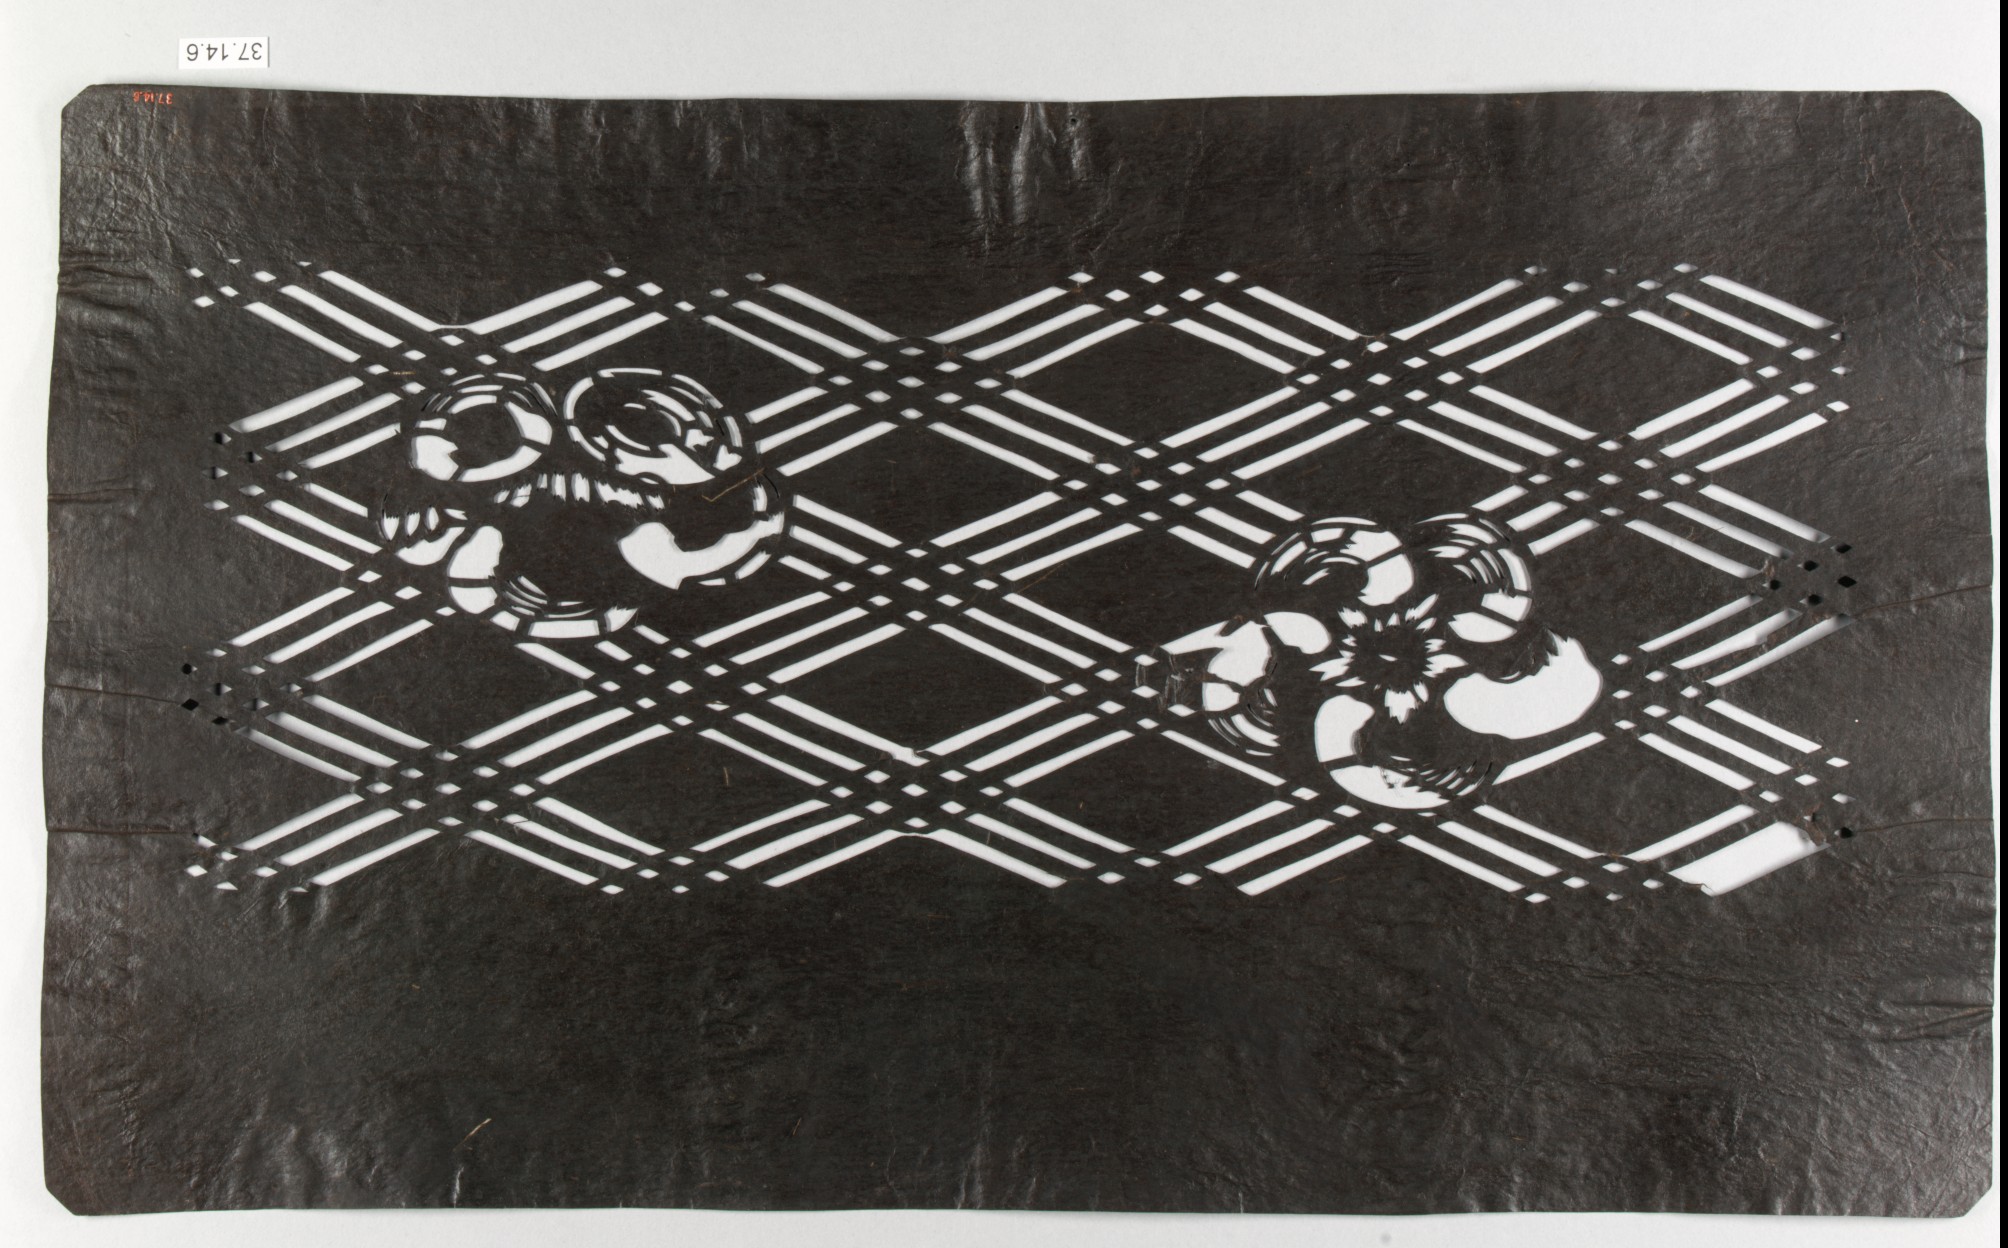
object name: stencil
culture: japanese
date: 1801-1833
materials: paper